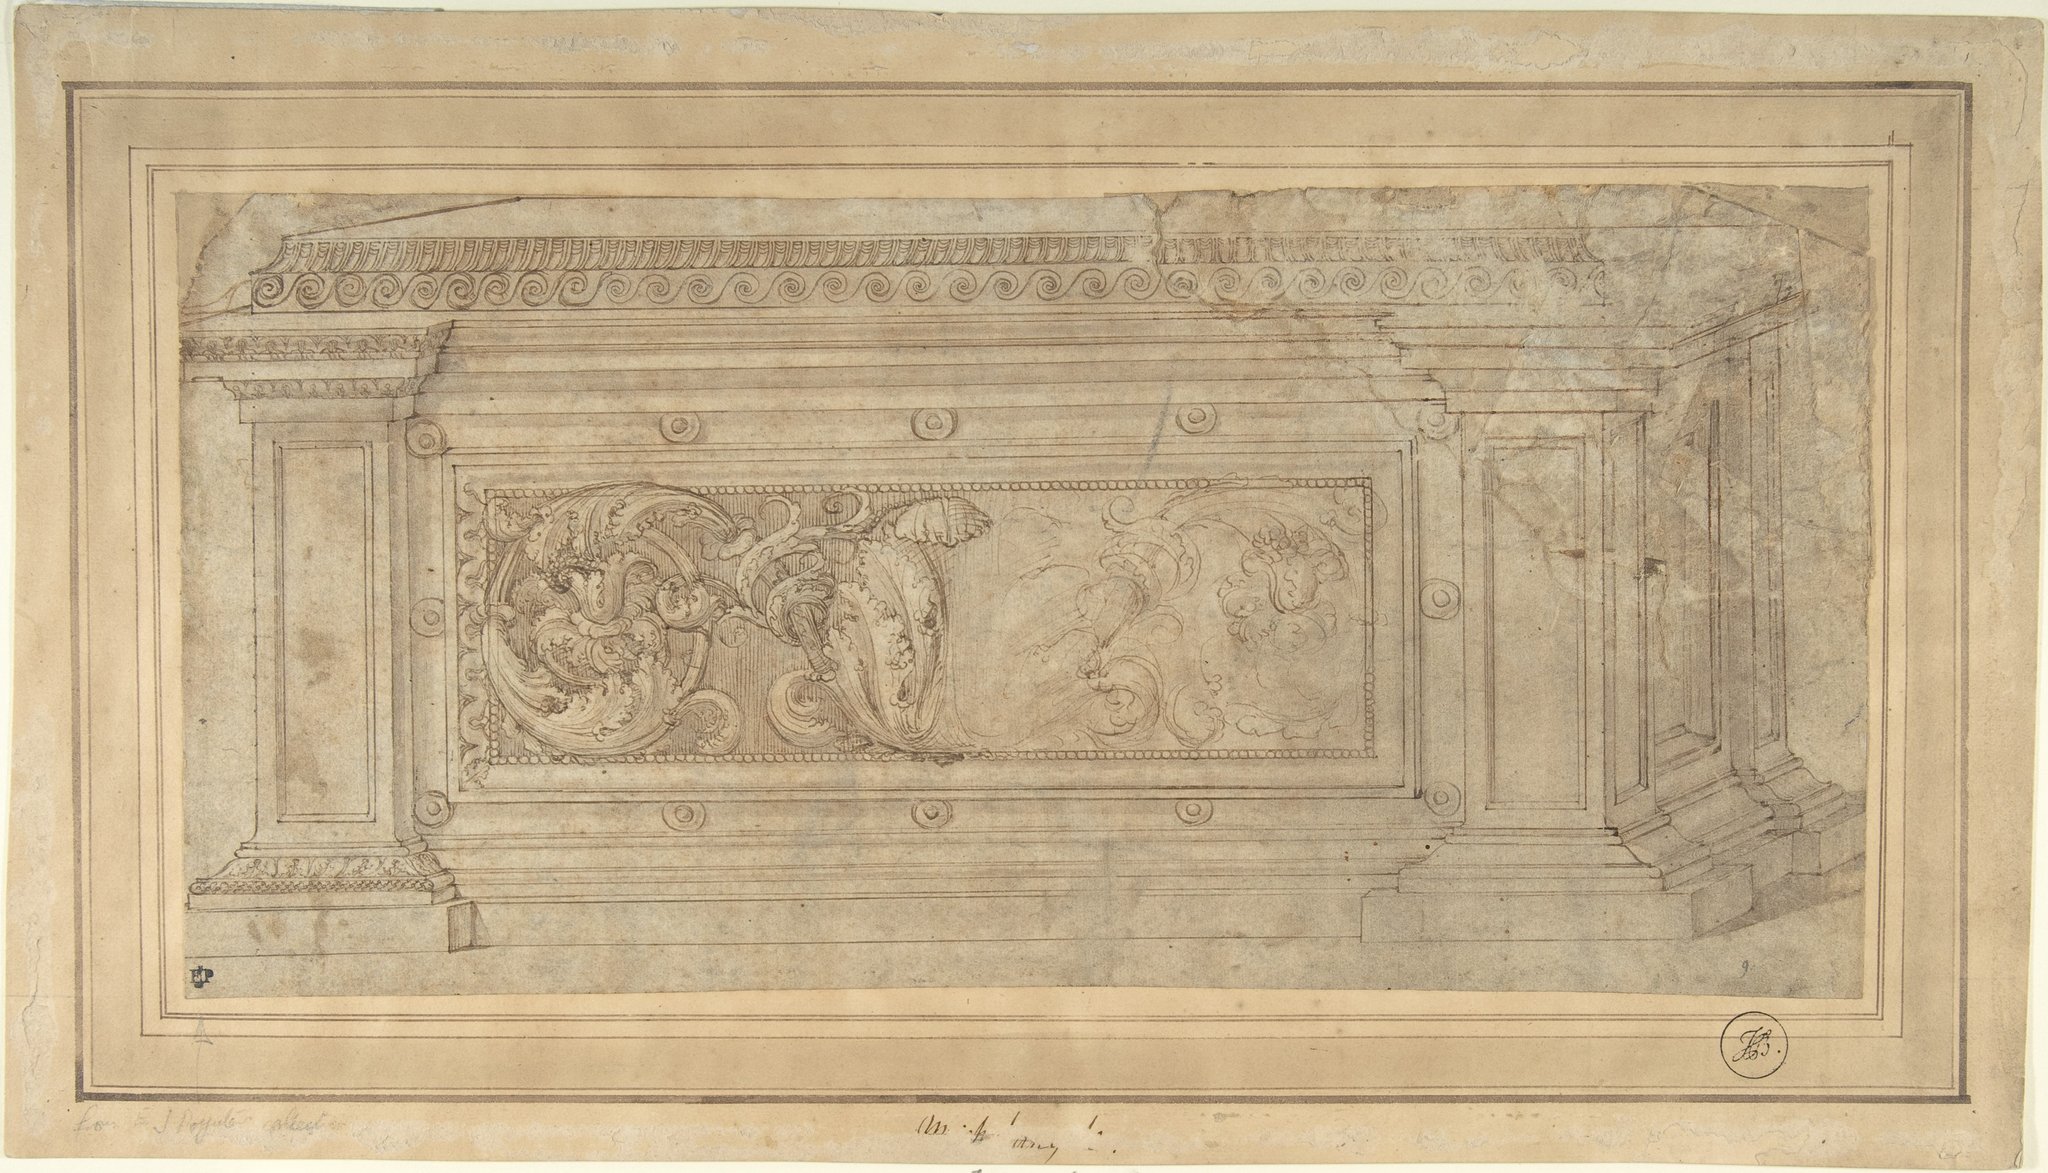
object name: drawing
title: Design for a Cassone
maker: anonymous, italian, 16th century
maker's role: artist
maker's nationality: italian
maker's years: 1550-1600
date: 1501-1533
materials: ink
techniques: pen, wash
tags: chests